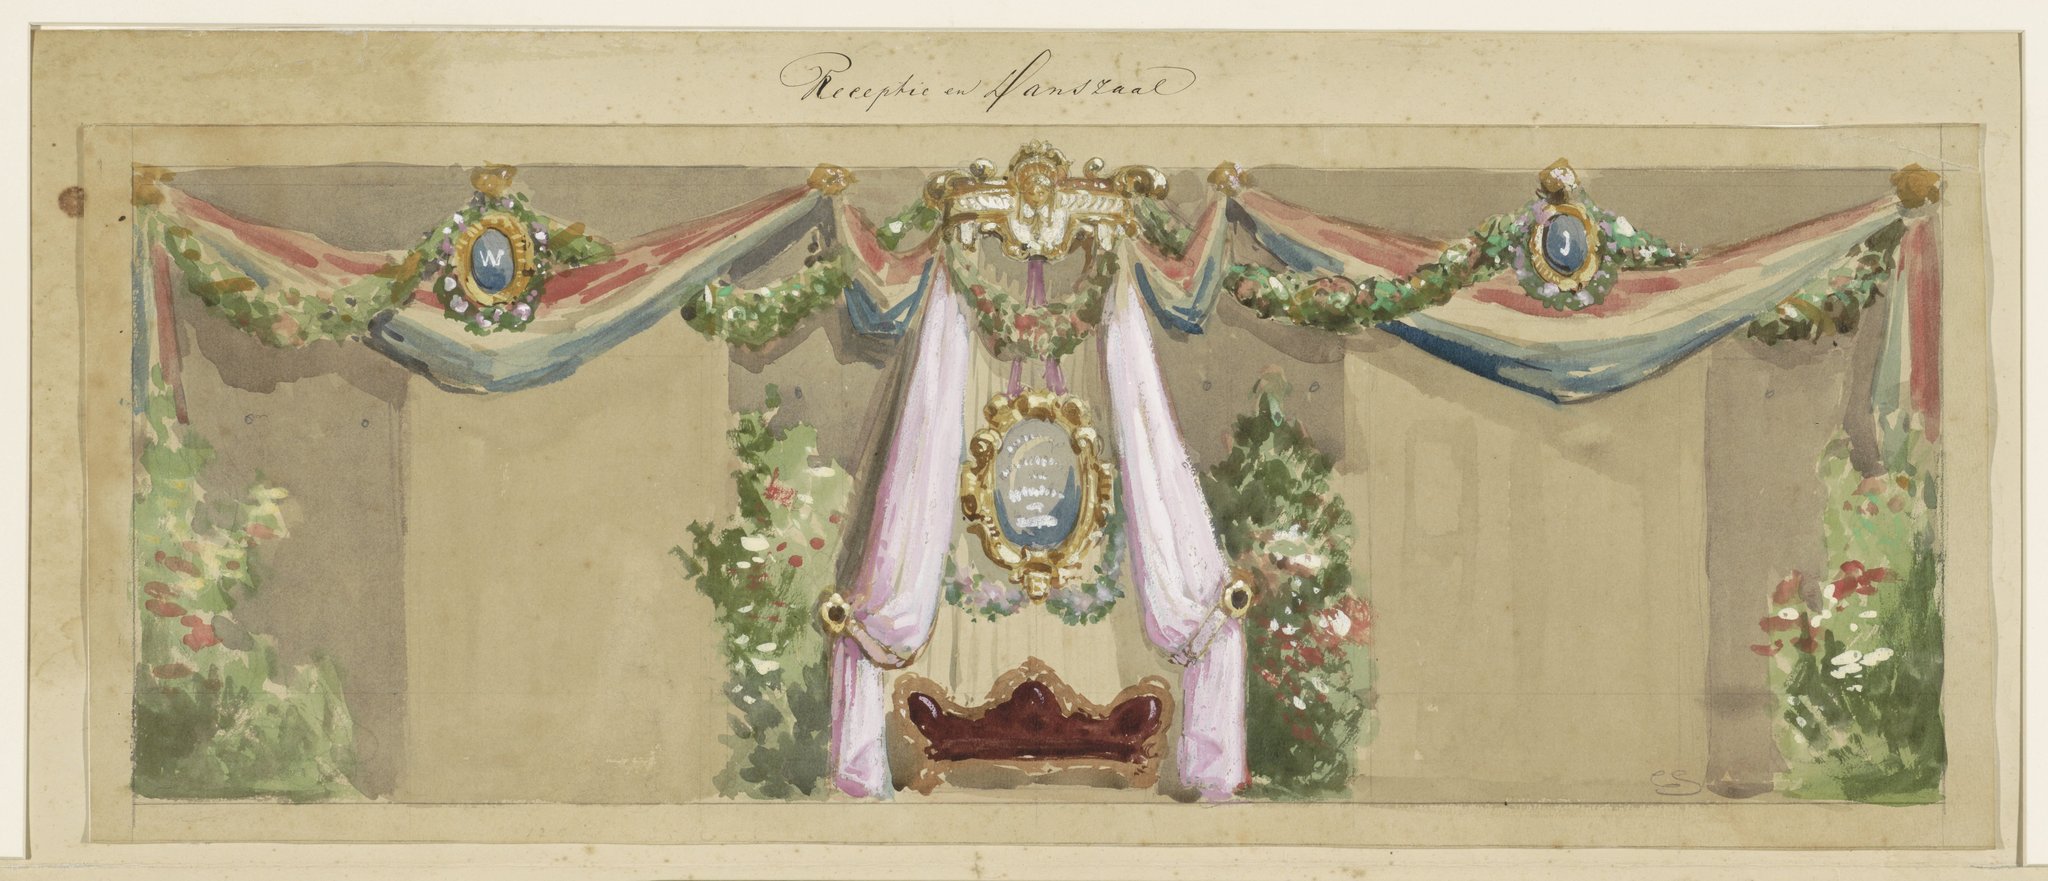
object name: watercolor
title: Ontwerp voor de feestdecoratie ter gelegenheid van het zilveren huwelijk van J.C. van Pappelendam en echtgenote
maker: cornelis springer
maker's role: draughtsman, painter, print maker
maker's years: 1817-1891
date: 1871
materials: paper, pencil, watercolor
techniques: brush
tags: johannes cornelis van pappelendam, silver anniversary, interior of the house, historical events and situations, amsterdam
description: Ontwerp voor de feestdecoratie ter gelegenheid van het zilveren huwelijk van J.C. van Pappelendam en echtgenote in de bovenzaal van Arti te Amsterdam.